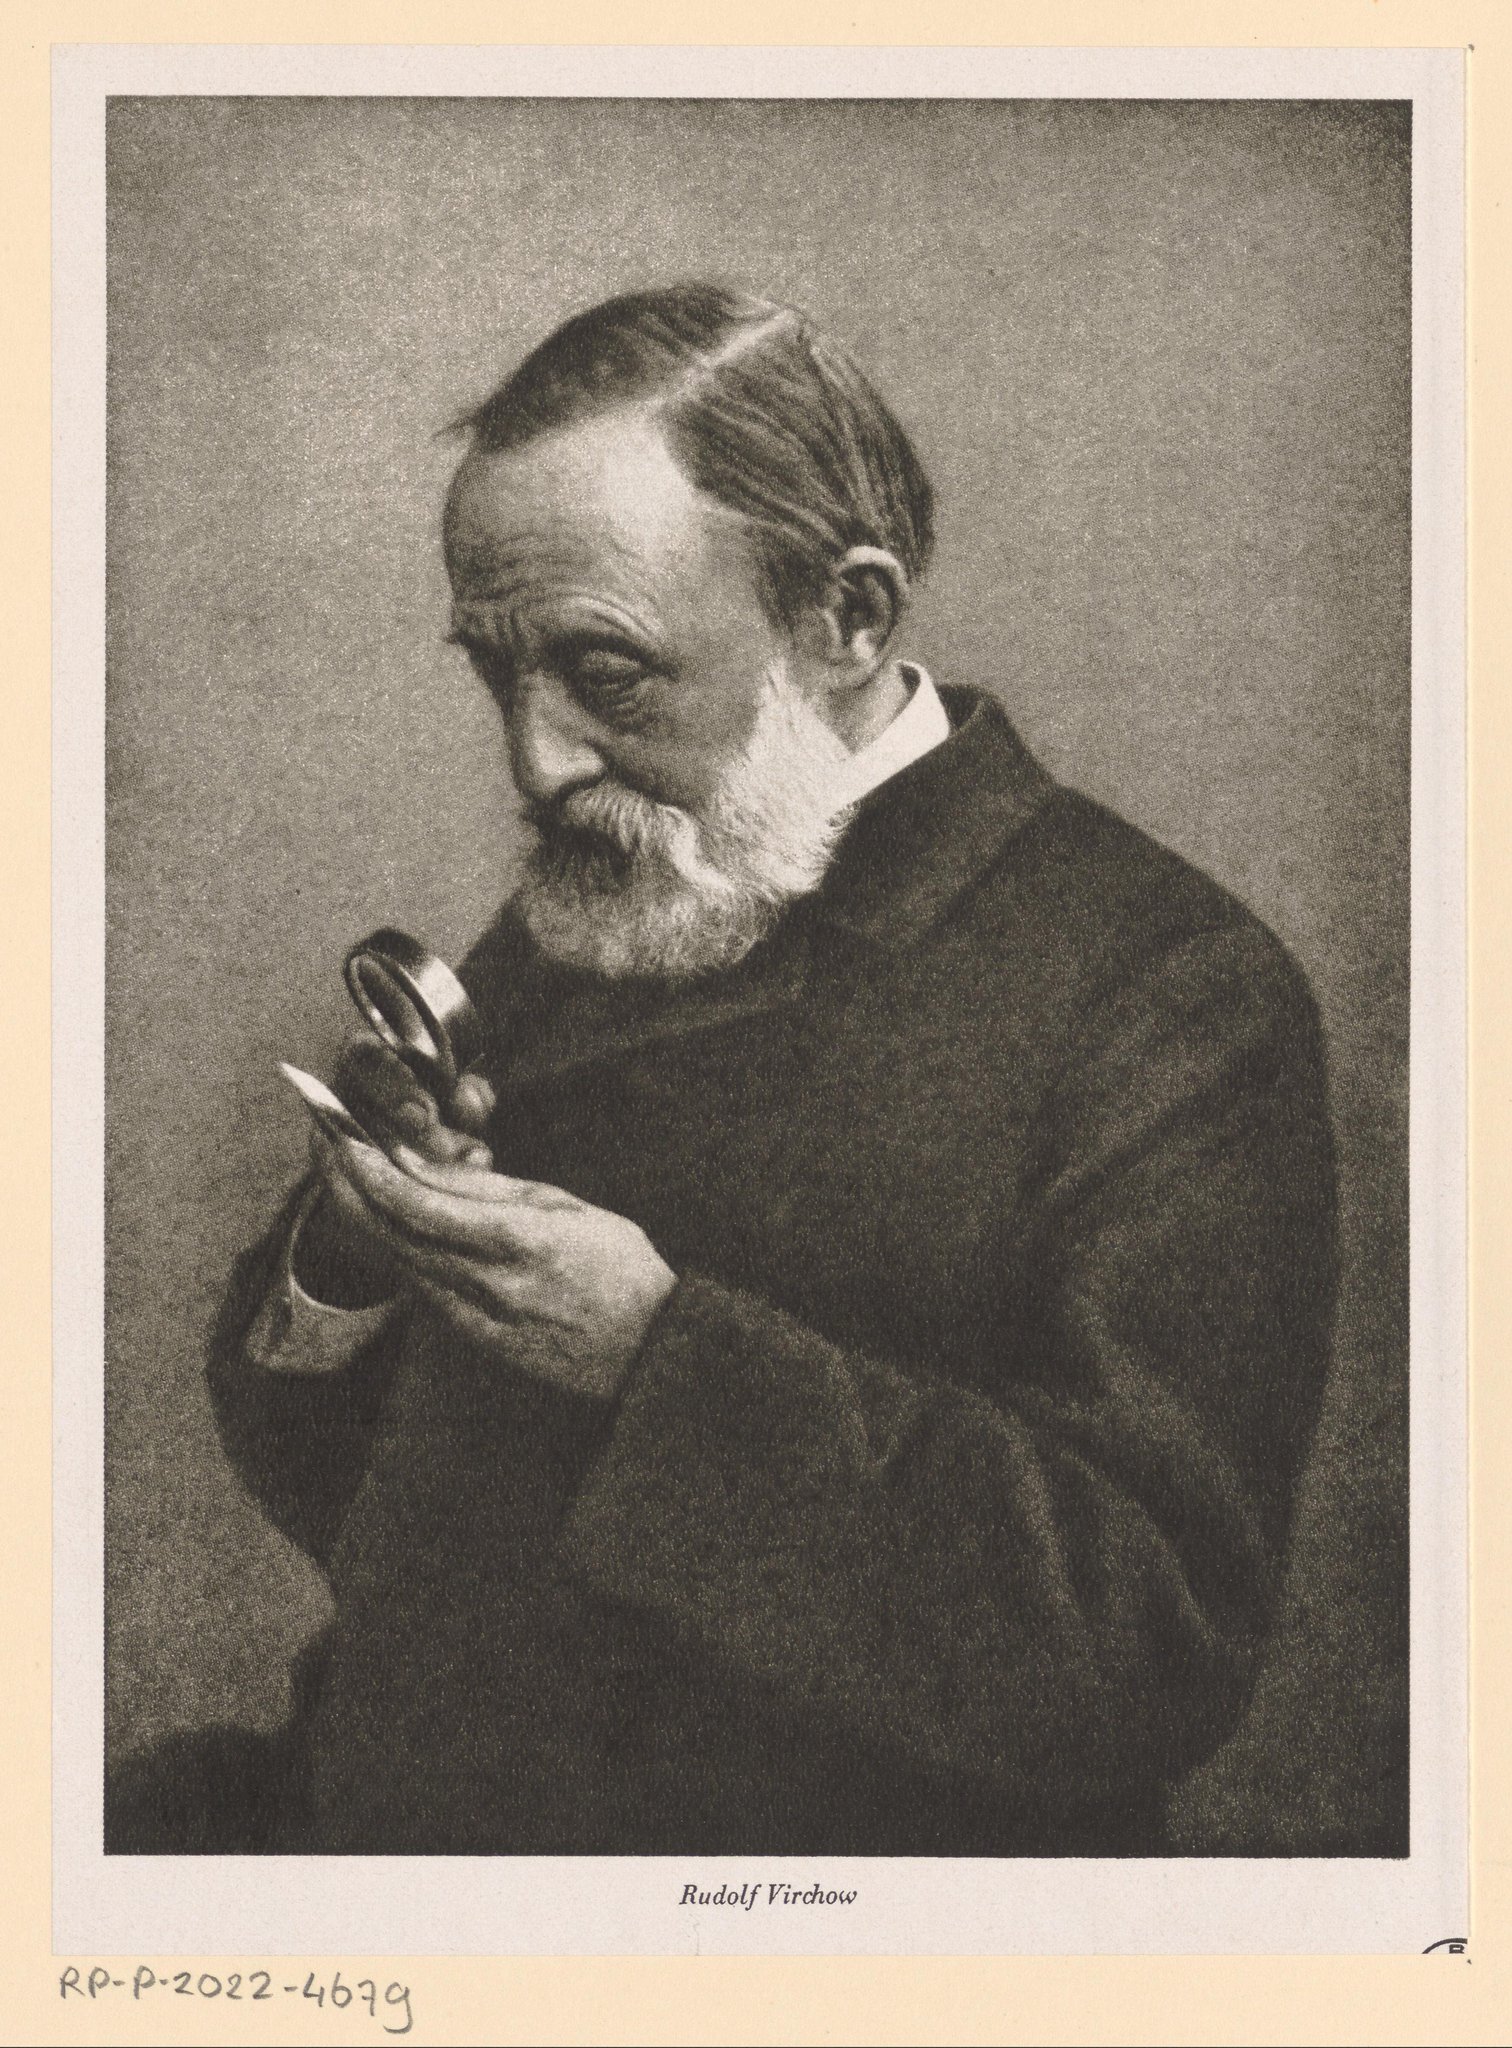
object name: photomechanical print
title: Portret van Rudolf Virchow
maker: Anonymous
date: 1902-2000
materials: paper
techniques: photochemical processes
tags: berlin, politician, scholar, philosopher, historical persons, physician, doctor, politician, e.g. party leader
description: fotomechanische afdruk komt uit een onbekende publicatie.